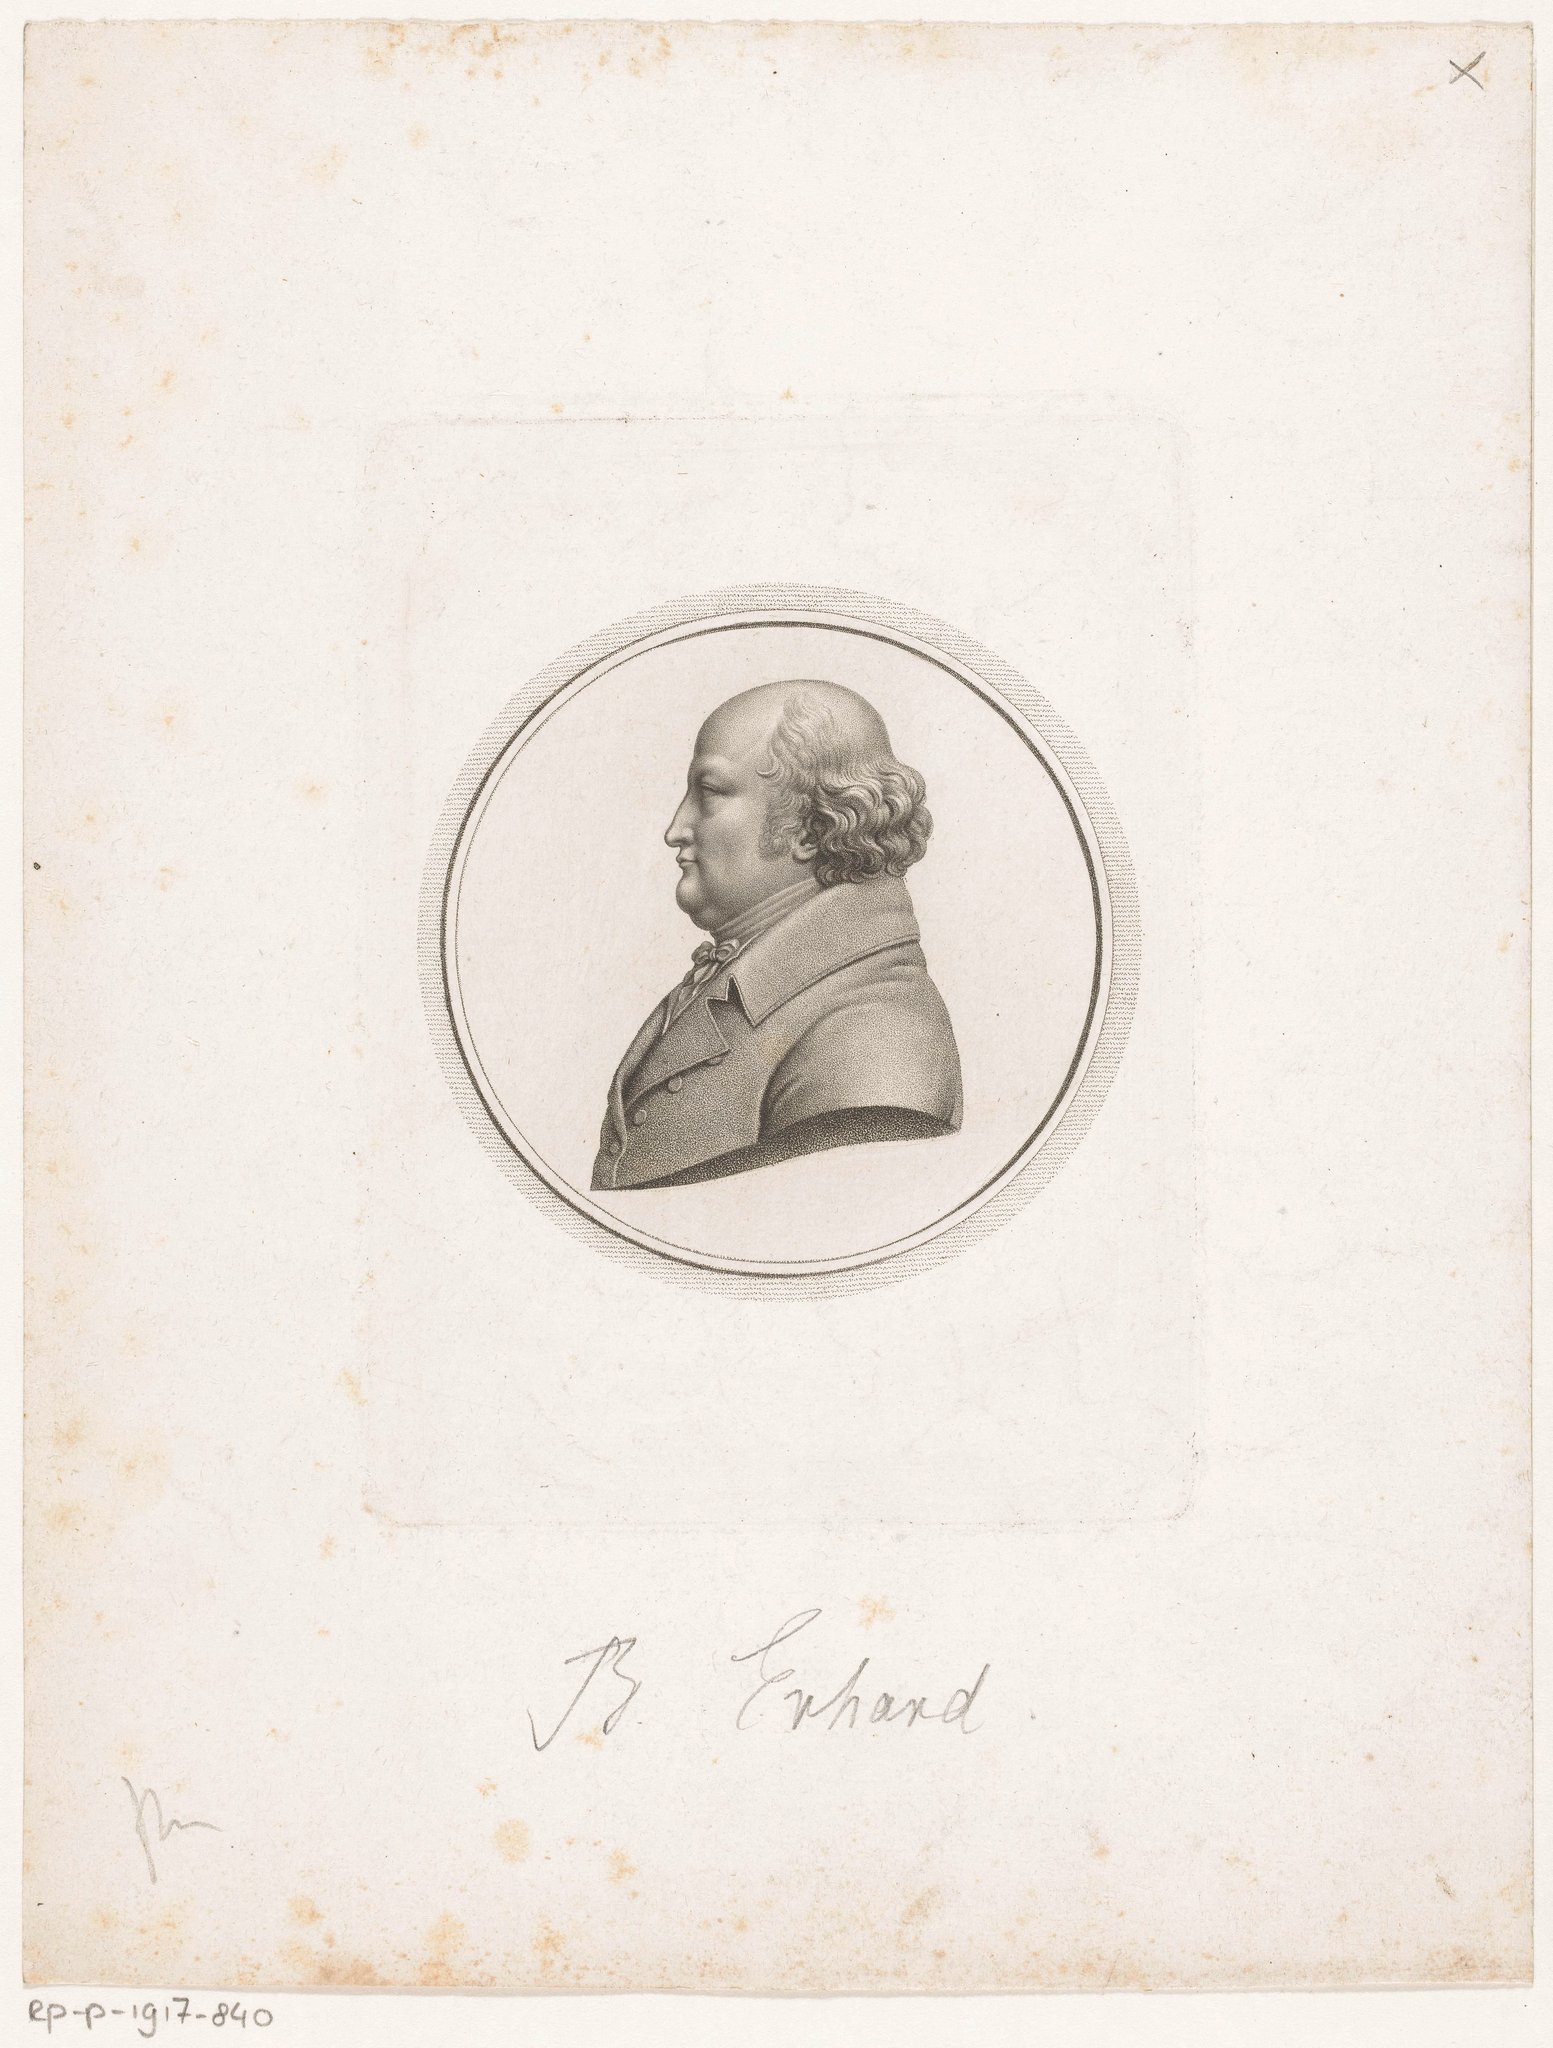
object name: print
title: Portret van Johann Benjamin Erhard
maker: friedrich fleischmann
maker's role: print maker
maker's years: 1791-1834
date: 1801-1834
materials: paper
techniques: stippling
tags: historical persons, sculpture (+ relief ~ sculpture)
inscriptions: collector's mark: Lugt 2228